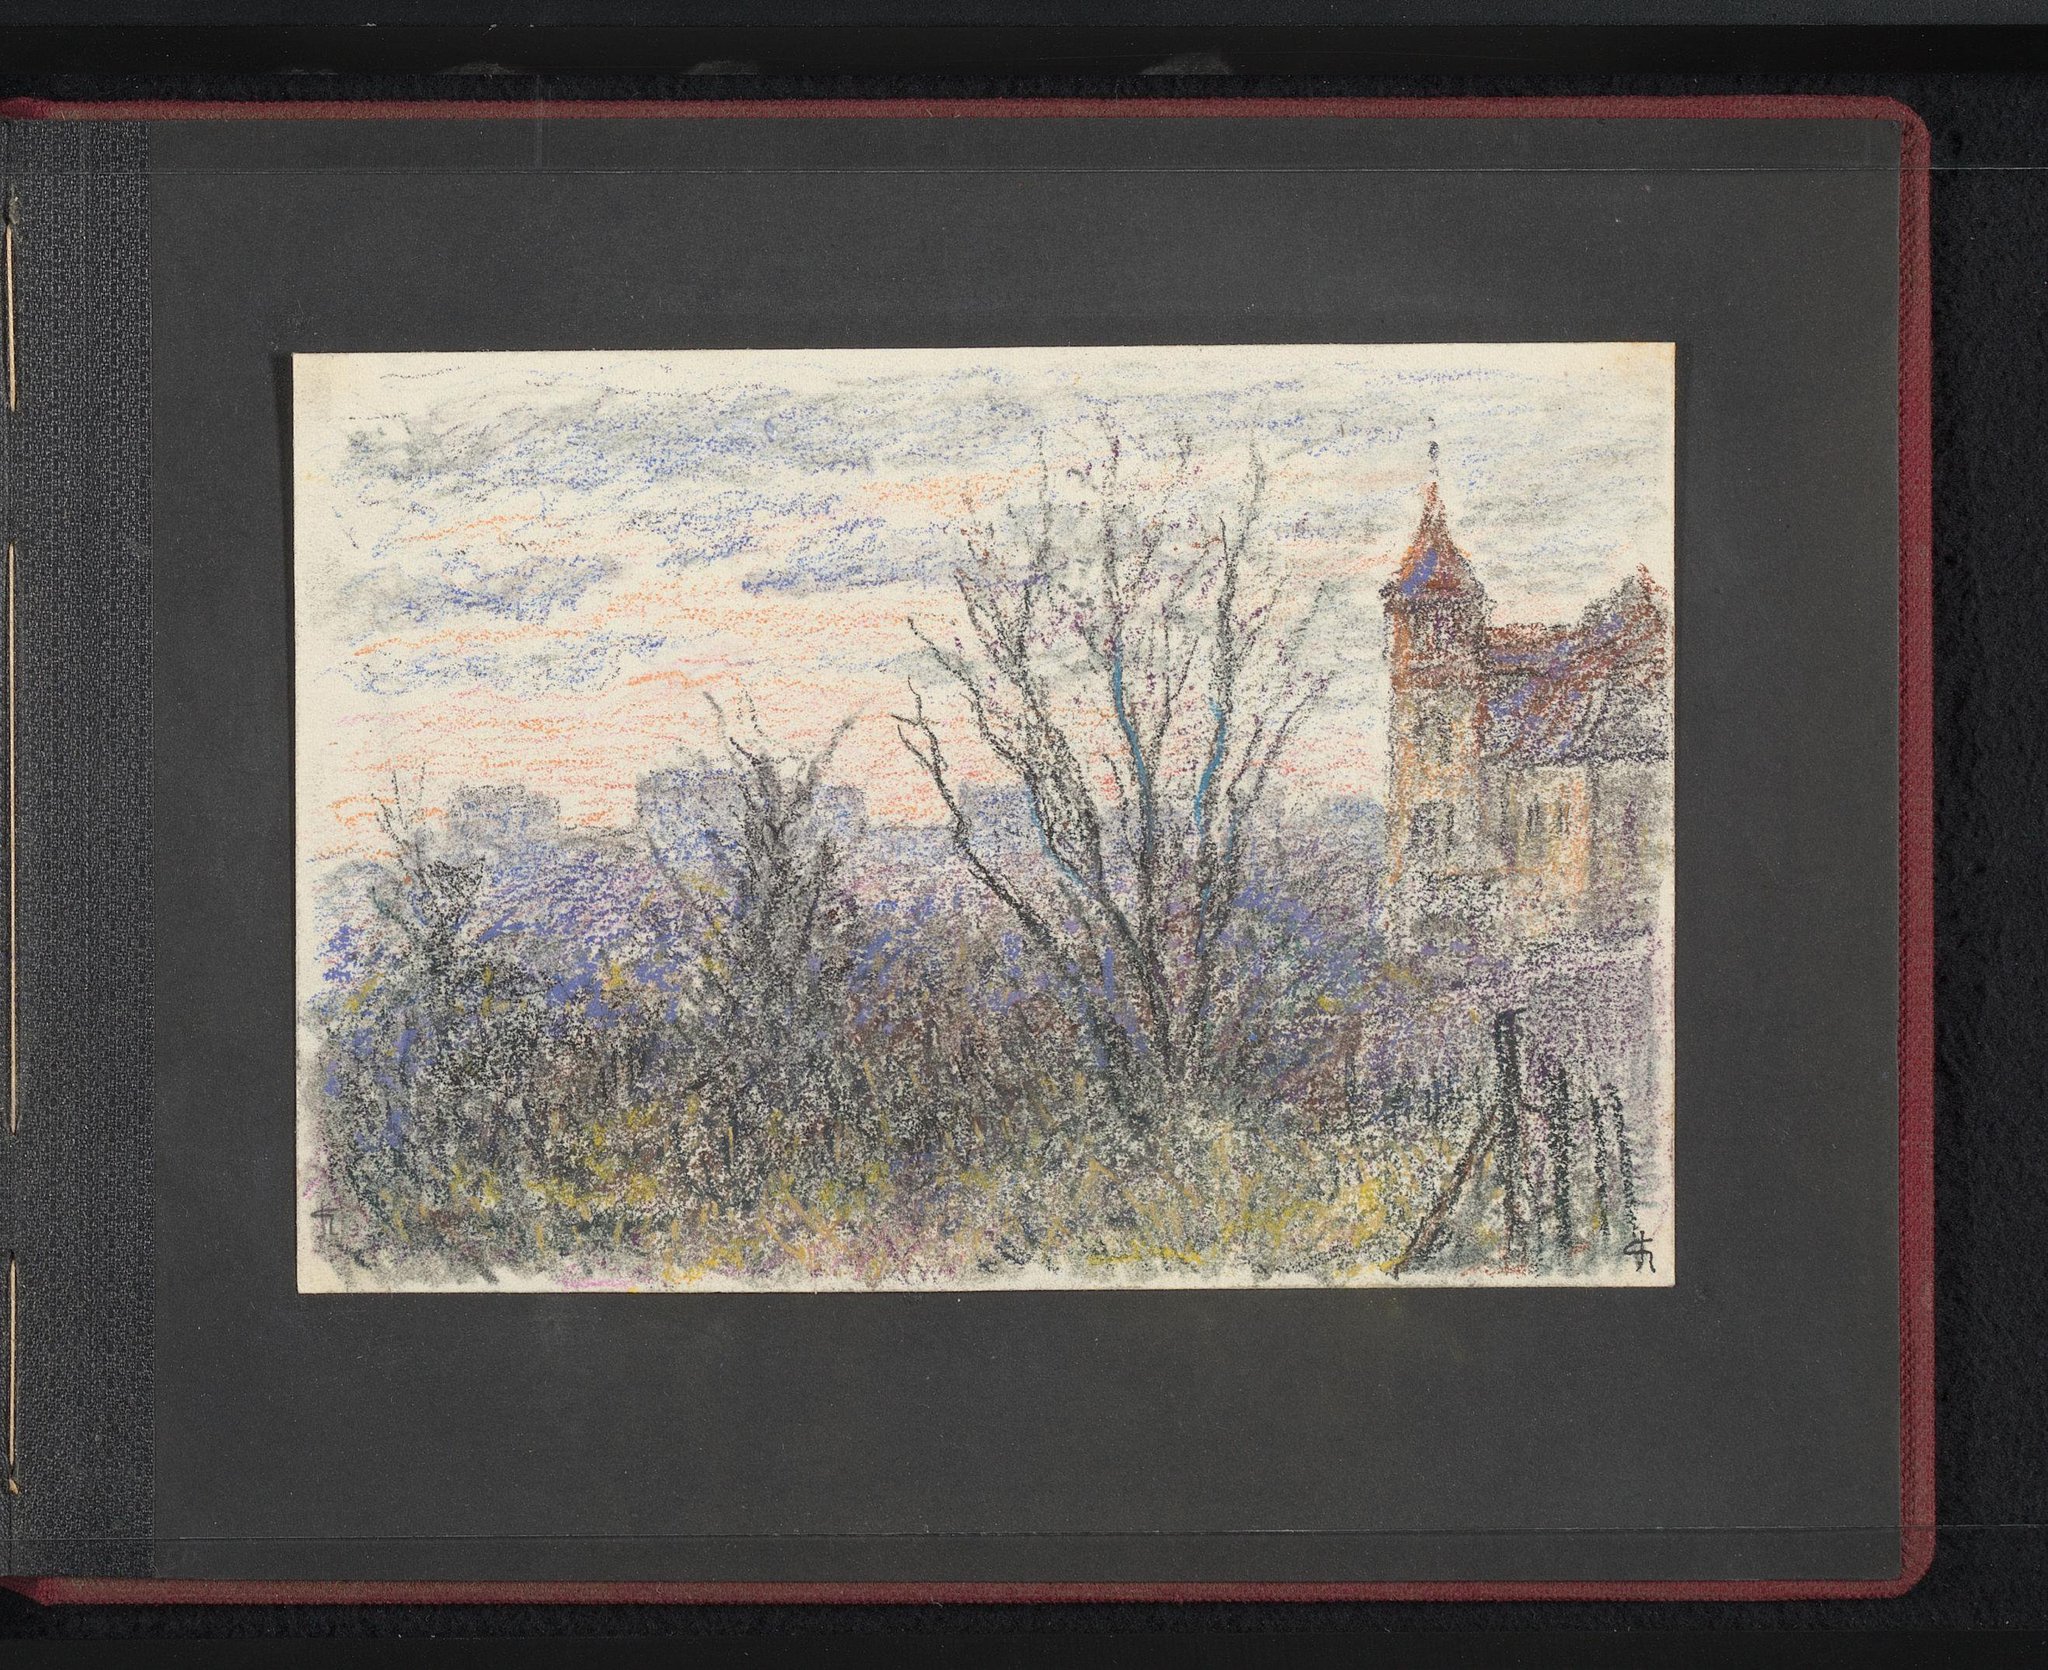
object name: drawing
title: Gezicht op een gebouw te Wiesbaden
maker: carel nicolaas storm van s-gravesande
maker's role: draughtsman, print maker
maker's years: 1841-1924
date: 1915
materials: chalk, paper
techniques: pasting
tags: city-view, and landscape with man-made constructions, civic architecture; edifices; dwellings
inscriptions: inscription: ‘Wiesbaden’